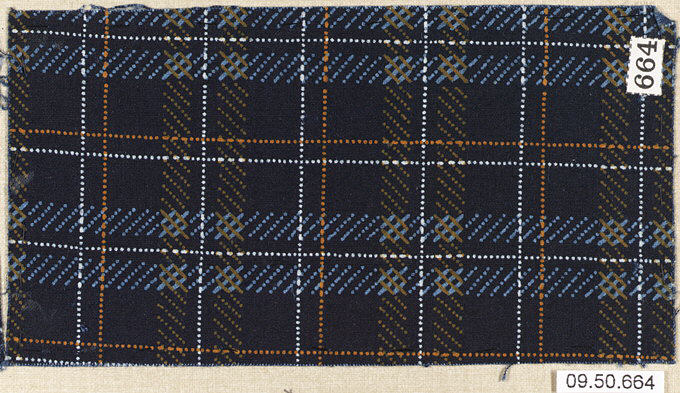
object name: piece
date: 1801-1900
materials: cotton